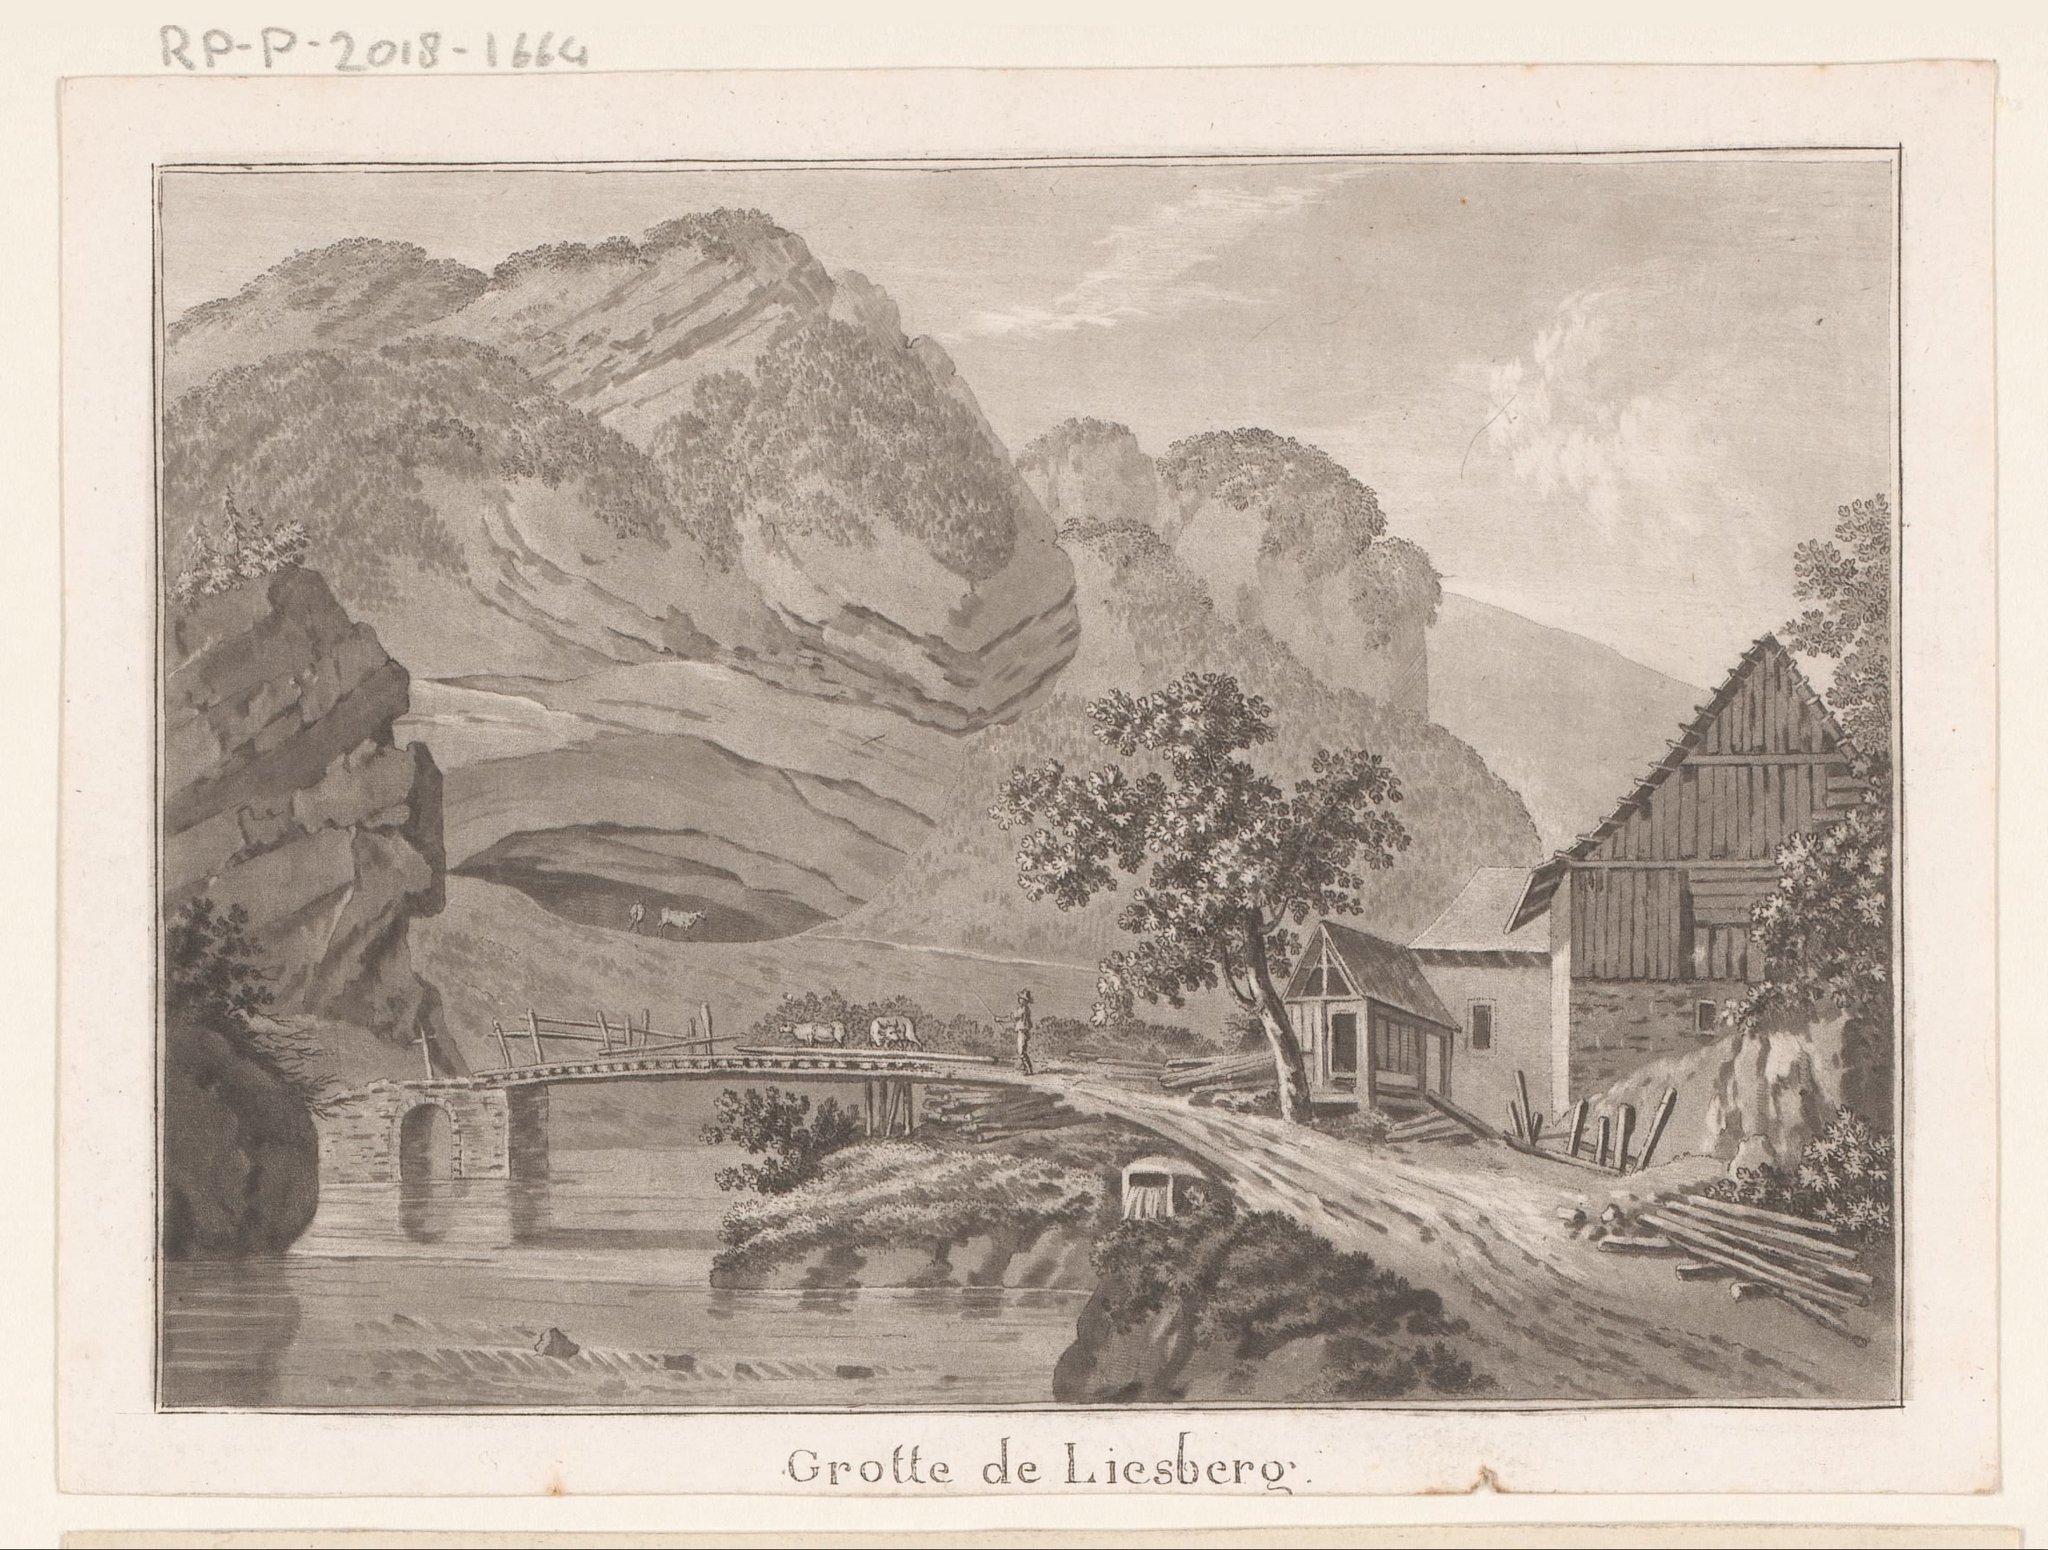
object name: print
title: Gezicht op een grot bij Liesberg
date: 1810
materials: paper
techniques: aquatint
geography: amsterdam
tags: cave, grotto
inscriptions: collector's mark: Lugt 2228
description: Prent ook gebruikt in: Promenade Pittoresque dans l'évêché de bâle aux bords de la Birs (...). Amsterdam: T.B. Groebe, 1710.